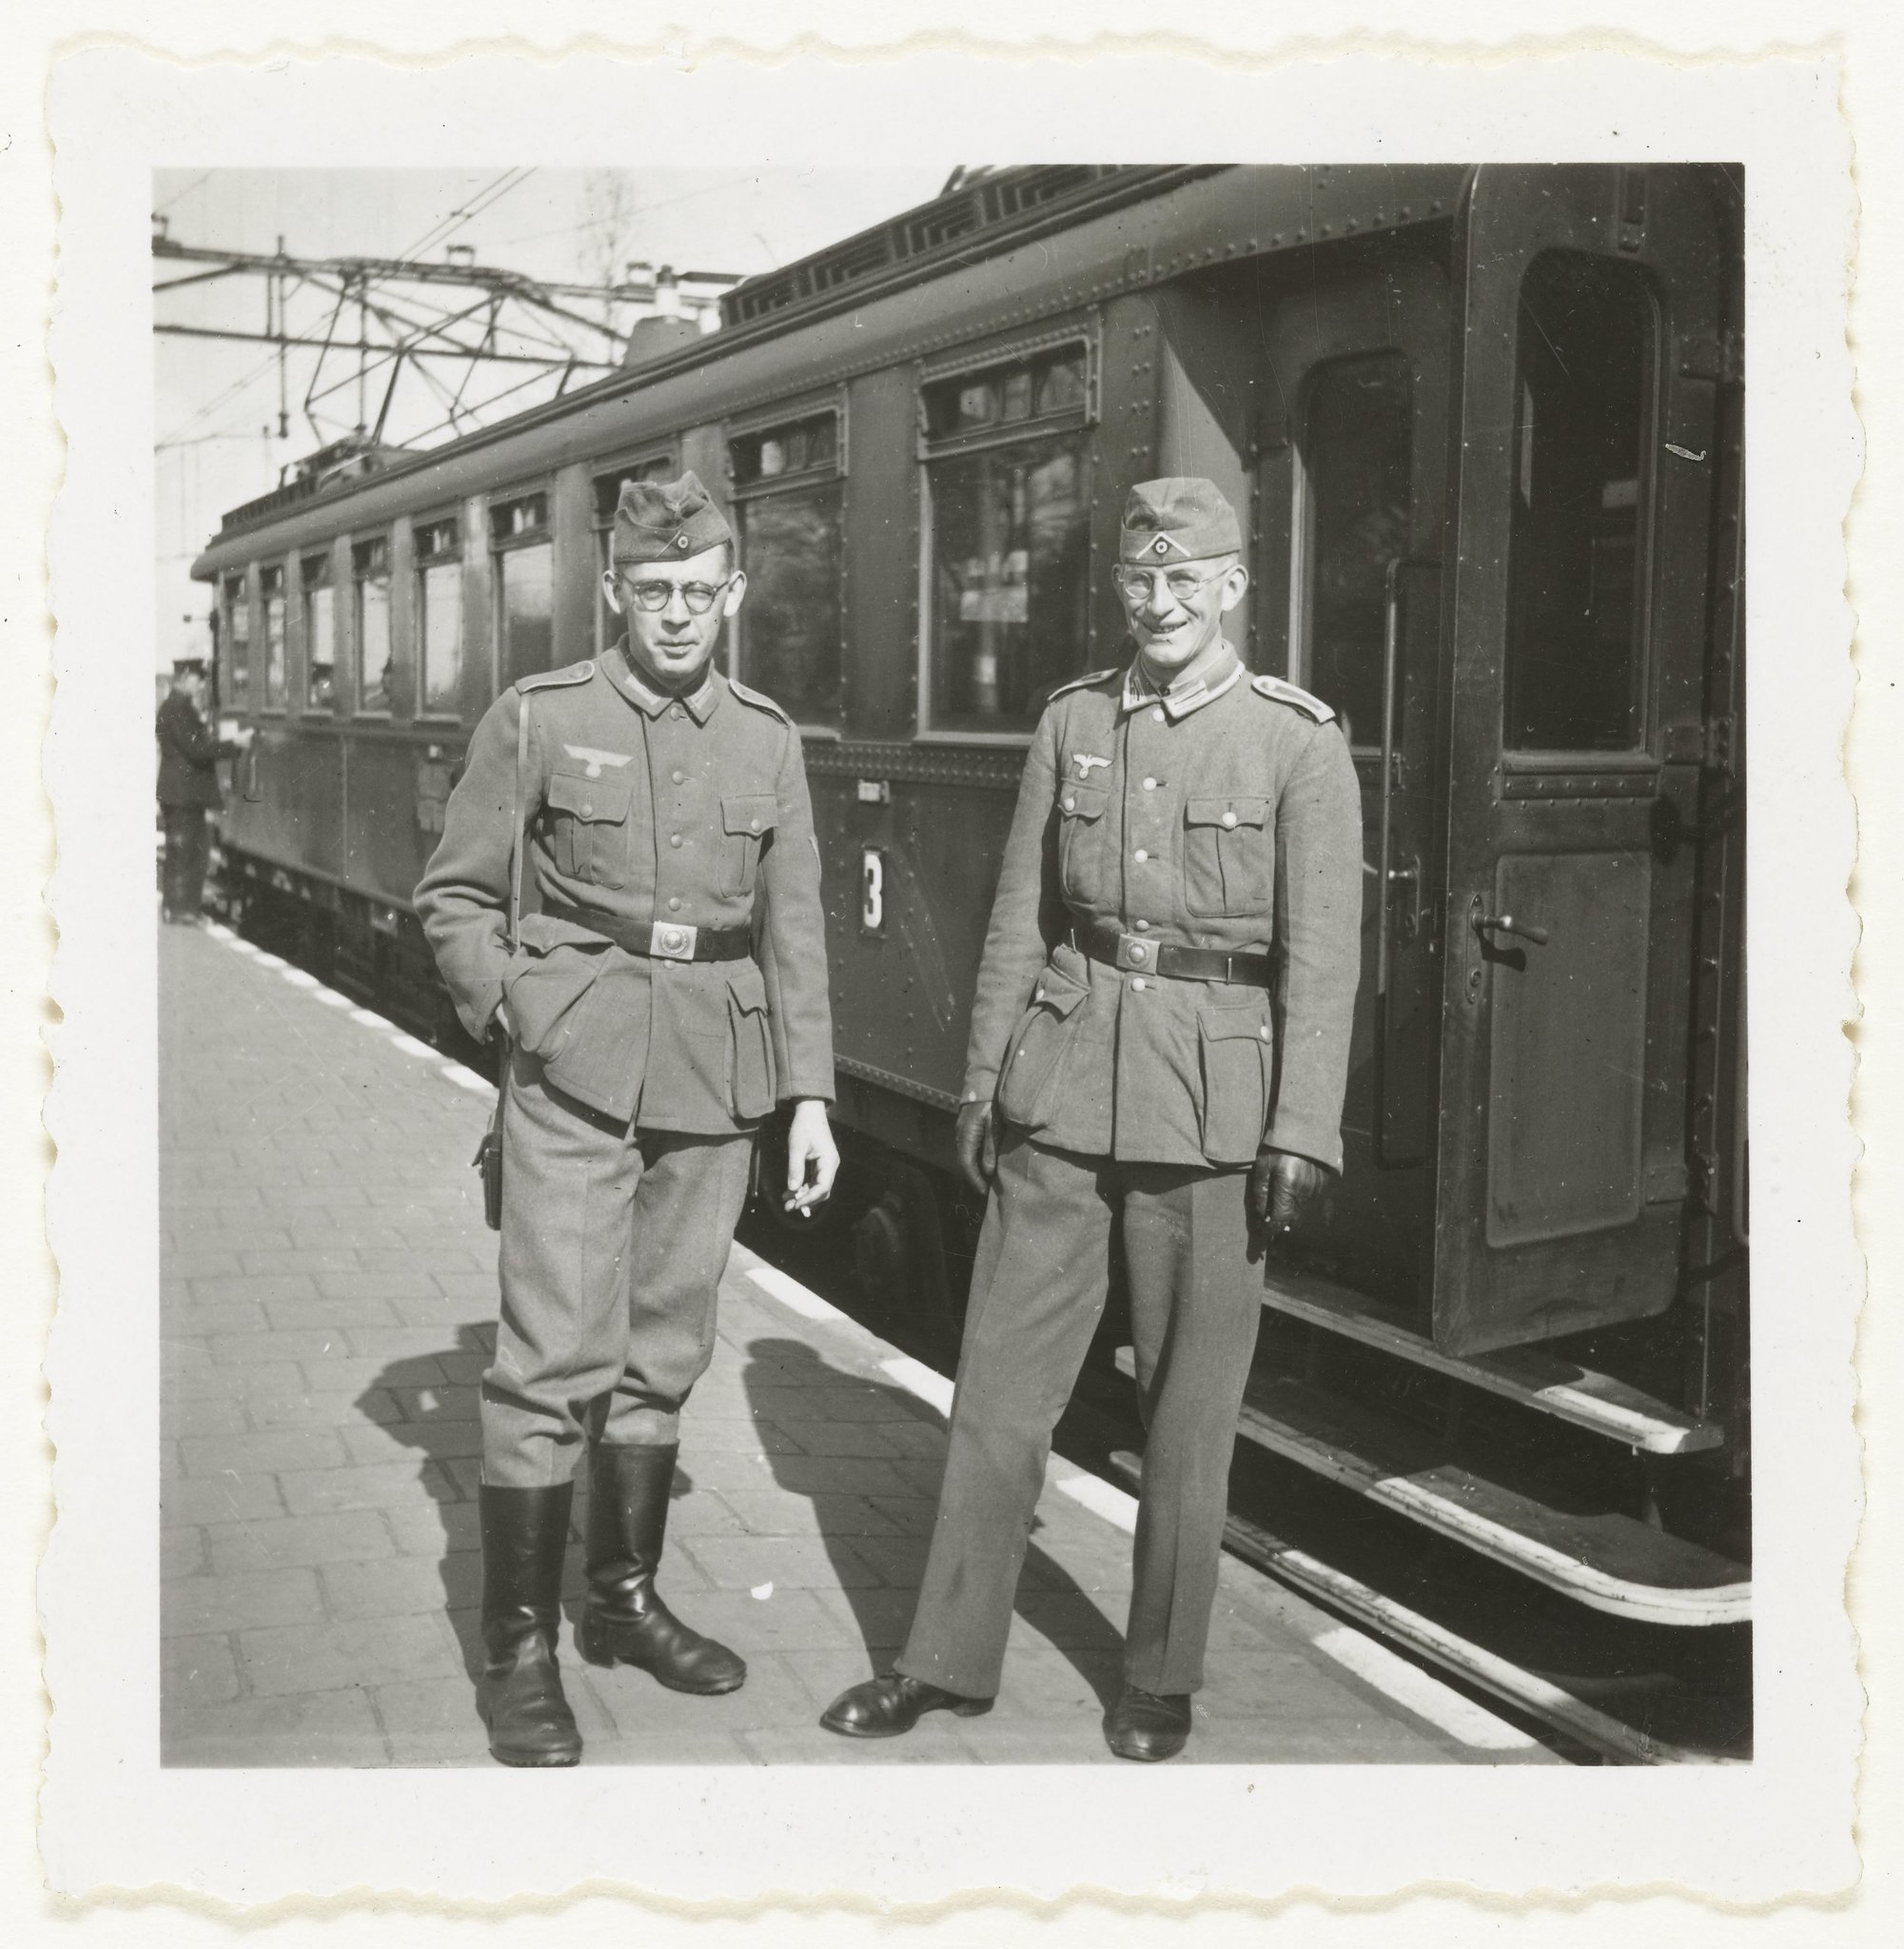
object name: photograph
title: Wehrmacht soldaten op het station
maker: Anonymous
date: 1941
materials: photographic support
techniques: gelatin silver print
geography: dordrecht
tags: army 'en route', passenger train, occupation ~ war, dordrecht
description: Twee Wehrmacht soldaten staan op het perron van een station. Achter hen een trein. De linker rookt een sigaret. Achterop staat: In Holland. 15.5.41. Auf dem Bahnhof in Dordrecht